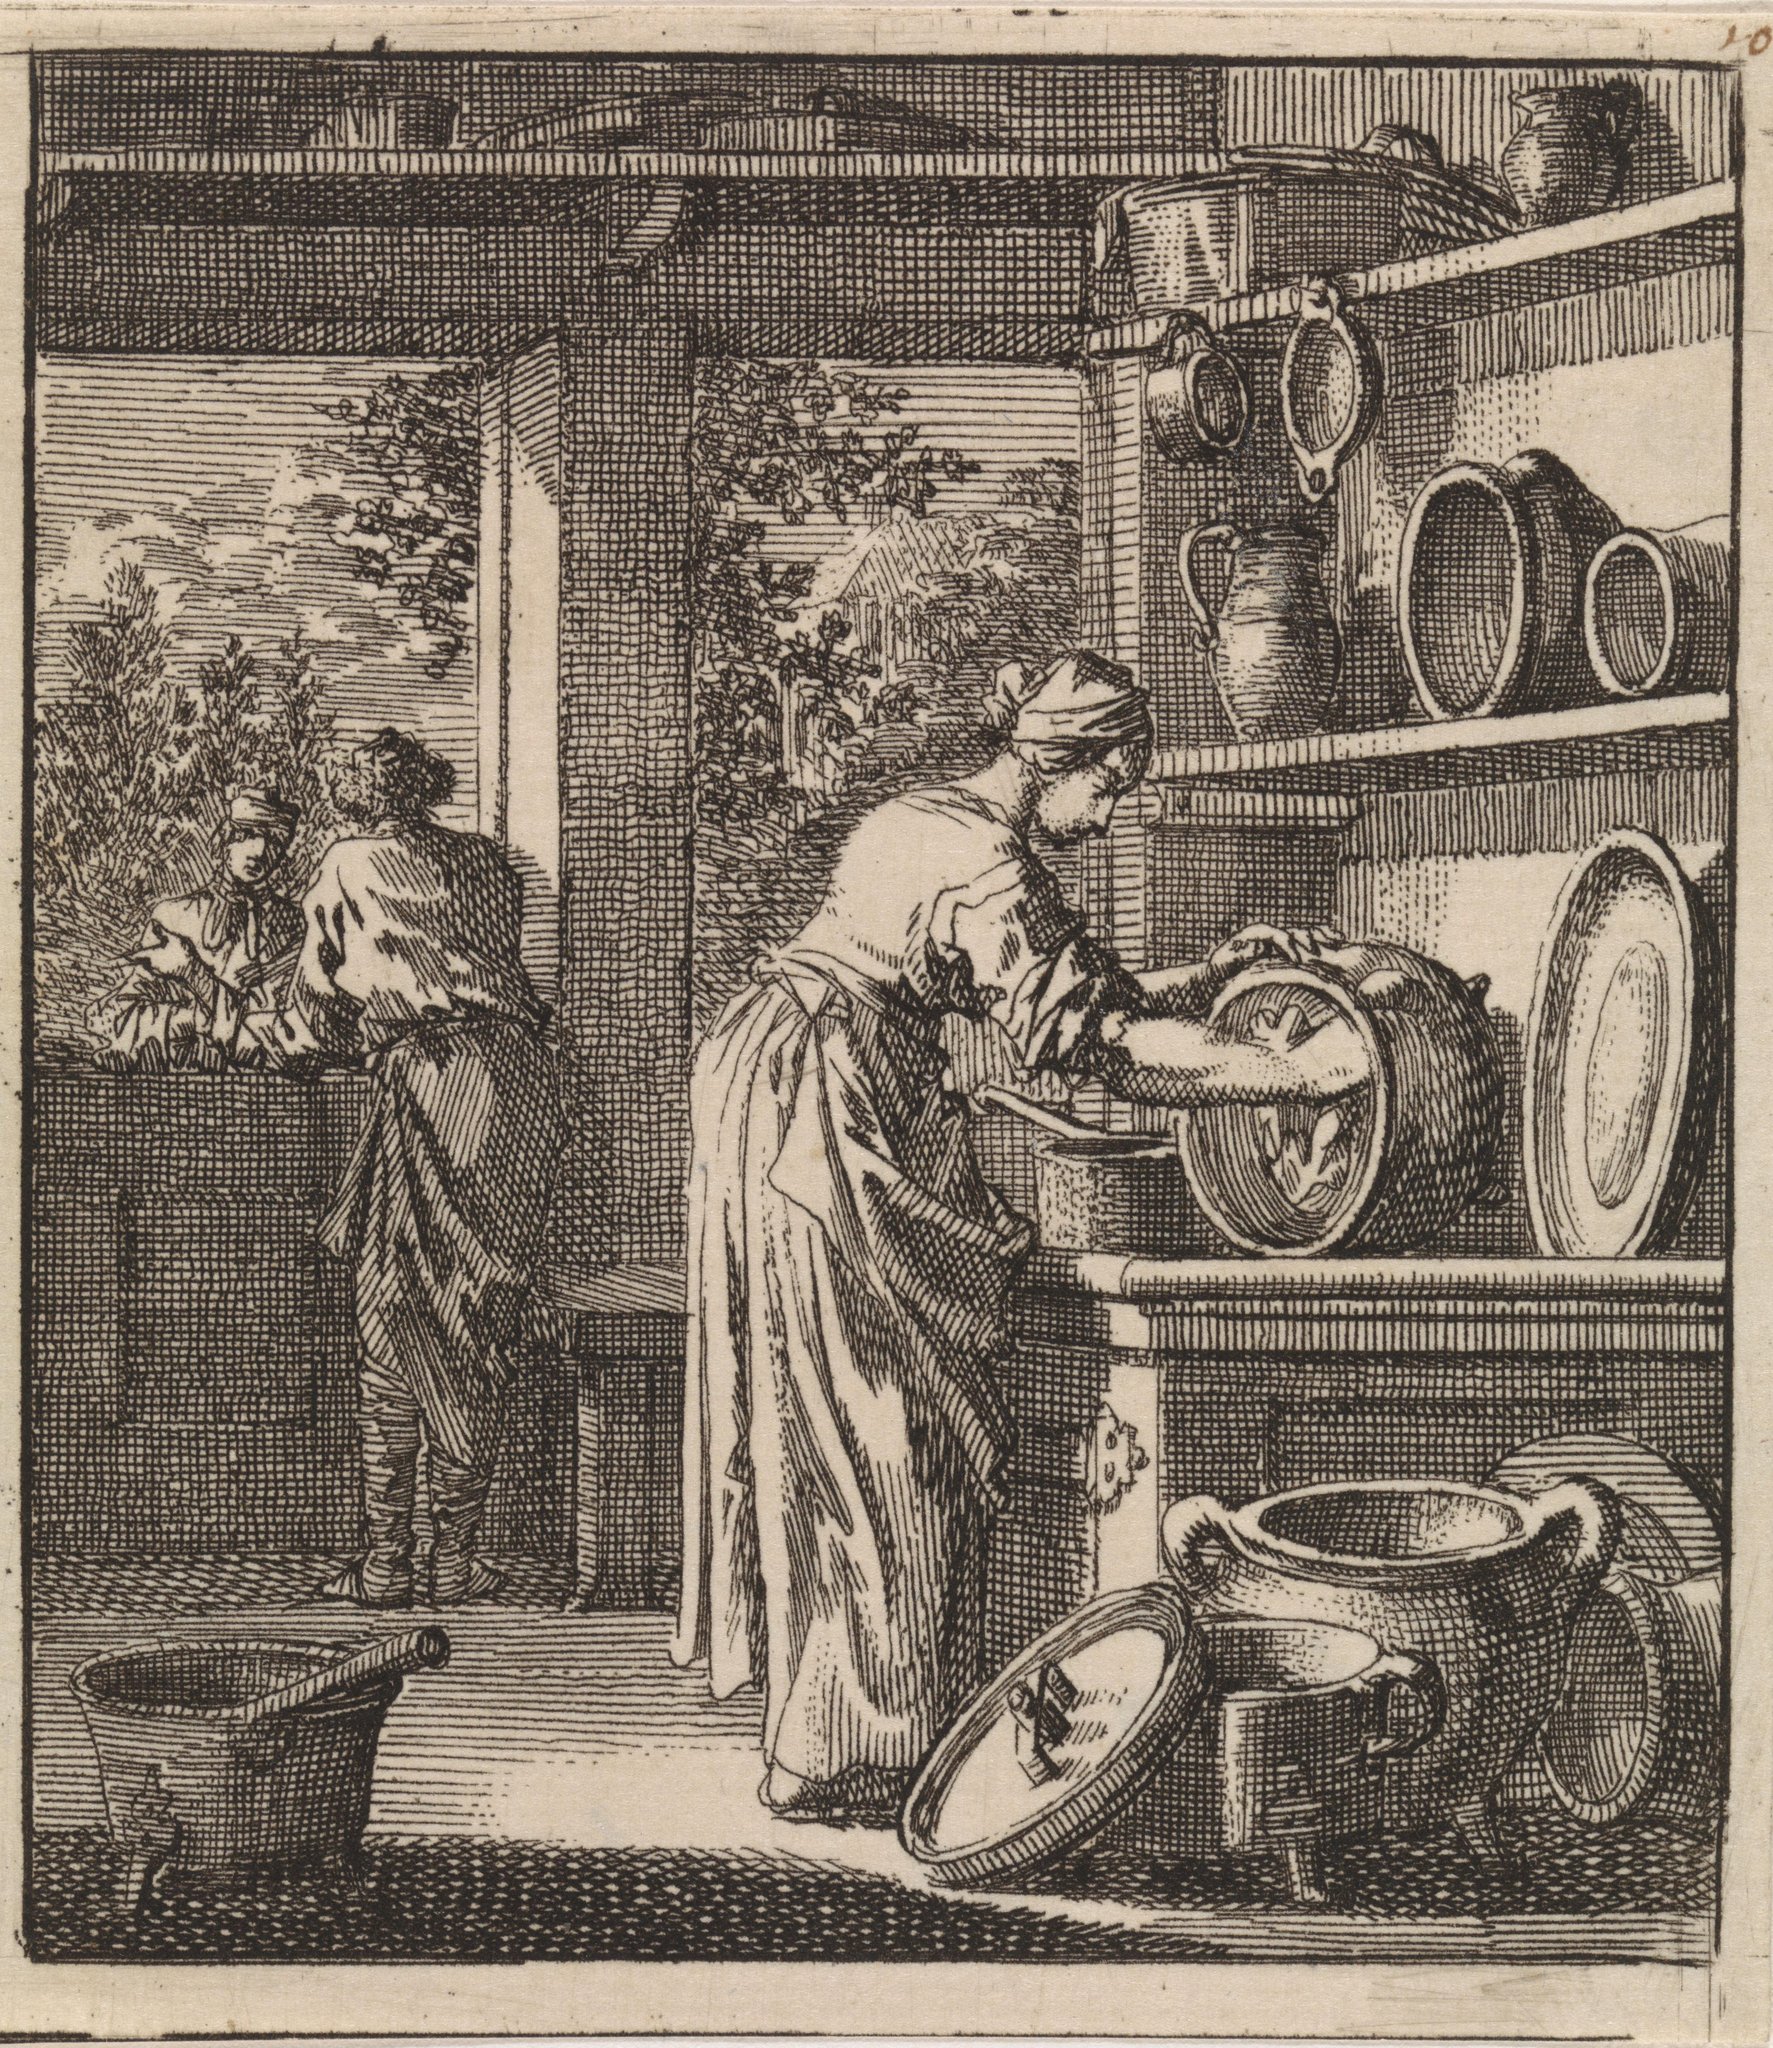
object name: print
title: De Pot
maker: jan luyken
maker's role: draughtsman, print maker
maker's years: 1649-1712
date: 1711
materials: paper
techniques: etching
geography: amsterdam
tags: kitchen-utensils: pan, kitchen-maid, kitchen servant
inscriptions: collector's mark: Lugt 2228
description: Proefdruk van illustratie voor: Luyken, Jan. Het leerzaam huisraad, vertoond in vyftig konstige figuuren, met godlyke spreuken en stichtelyke verzen: Pieter Arentsz. II (wed.) en Cornelis van der Sys, 1711, p. 34.